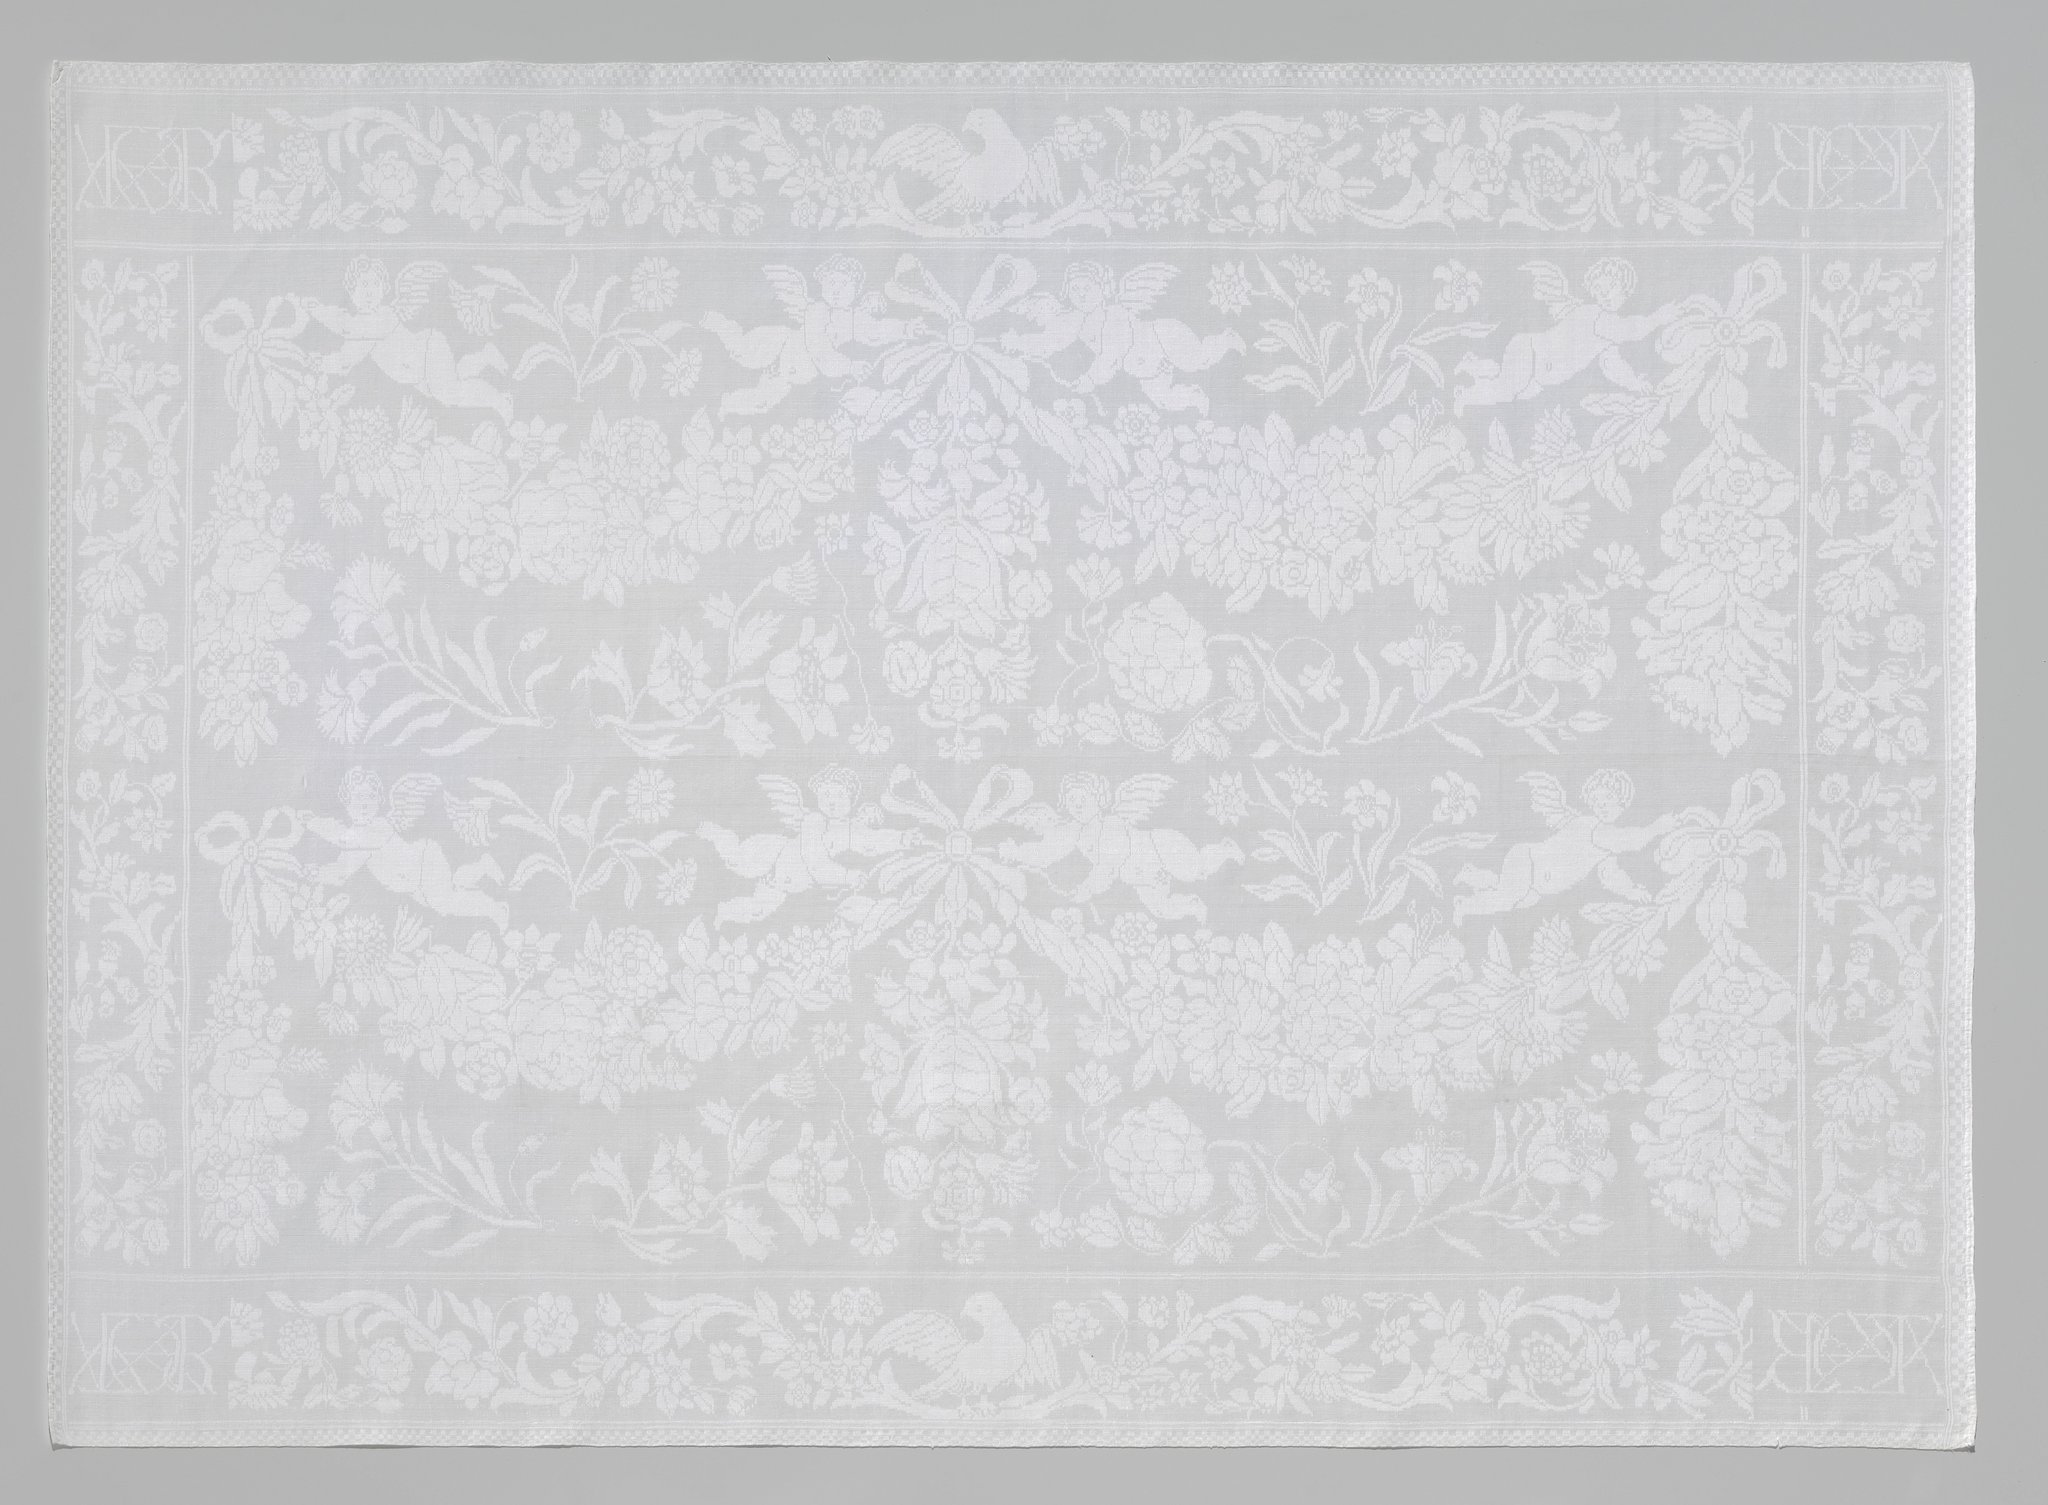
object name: woven material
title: Servet van wit linnendamast met patroon van putti met siertrossen en monogram in de hoeken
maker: Anonymous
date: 1665-1675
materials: linen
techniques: damask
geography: netherlands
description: Servet van wit linnendamast met patroon van putti met siertrossen en monogram in de hoeken. Satijn 5 binding.